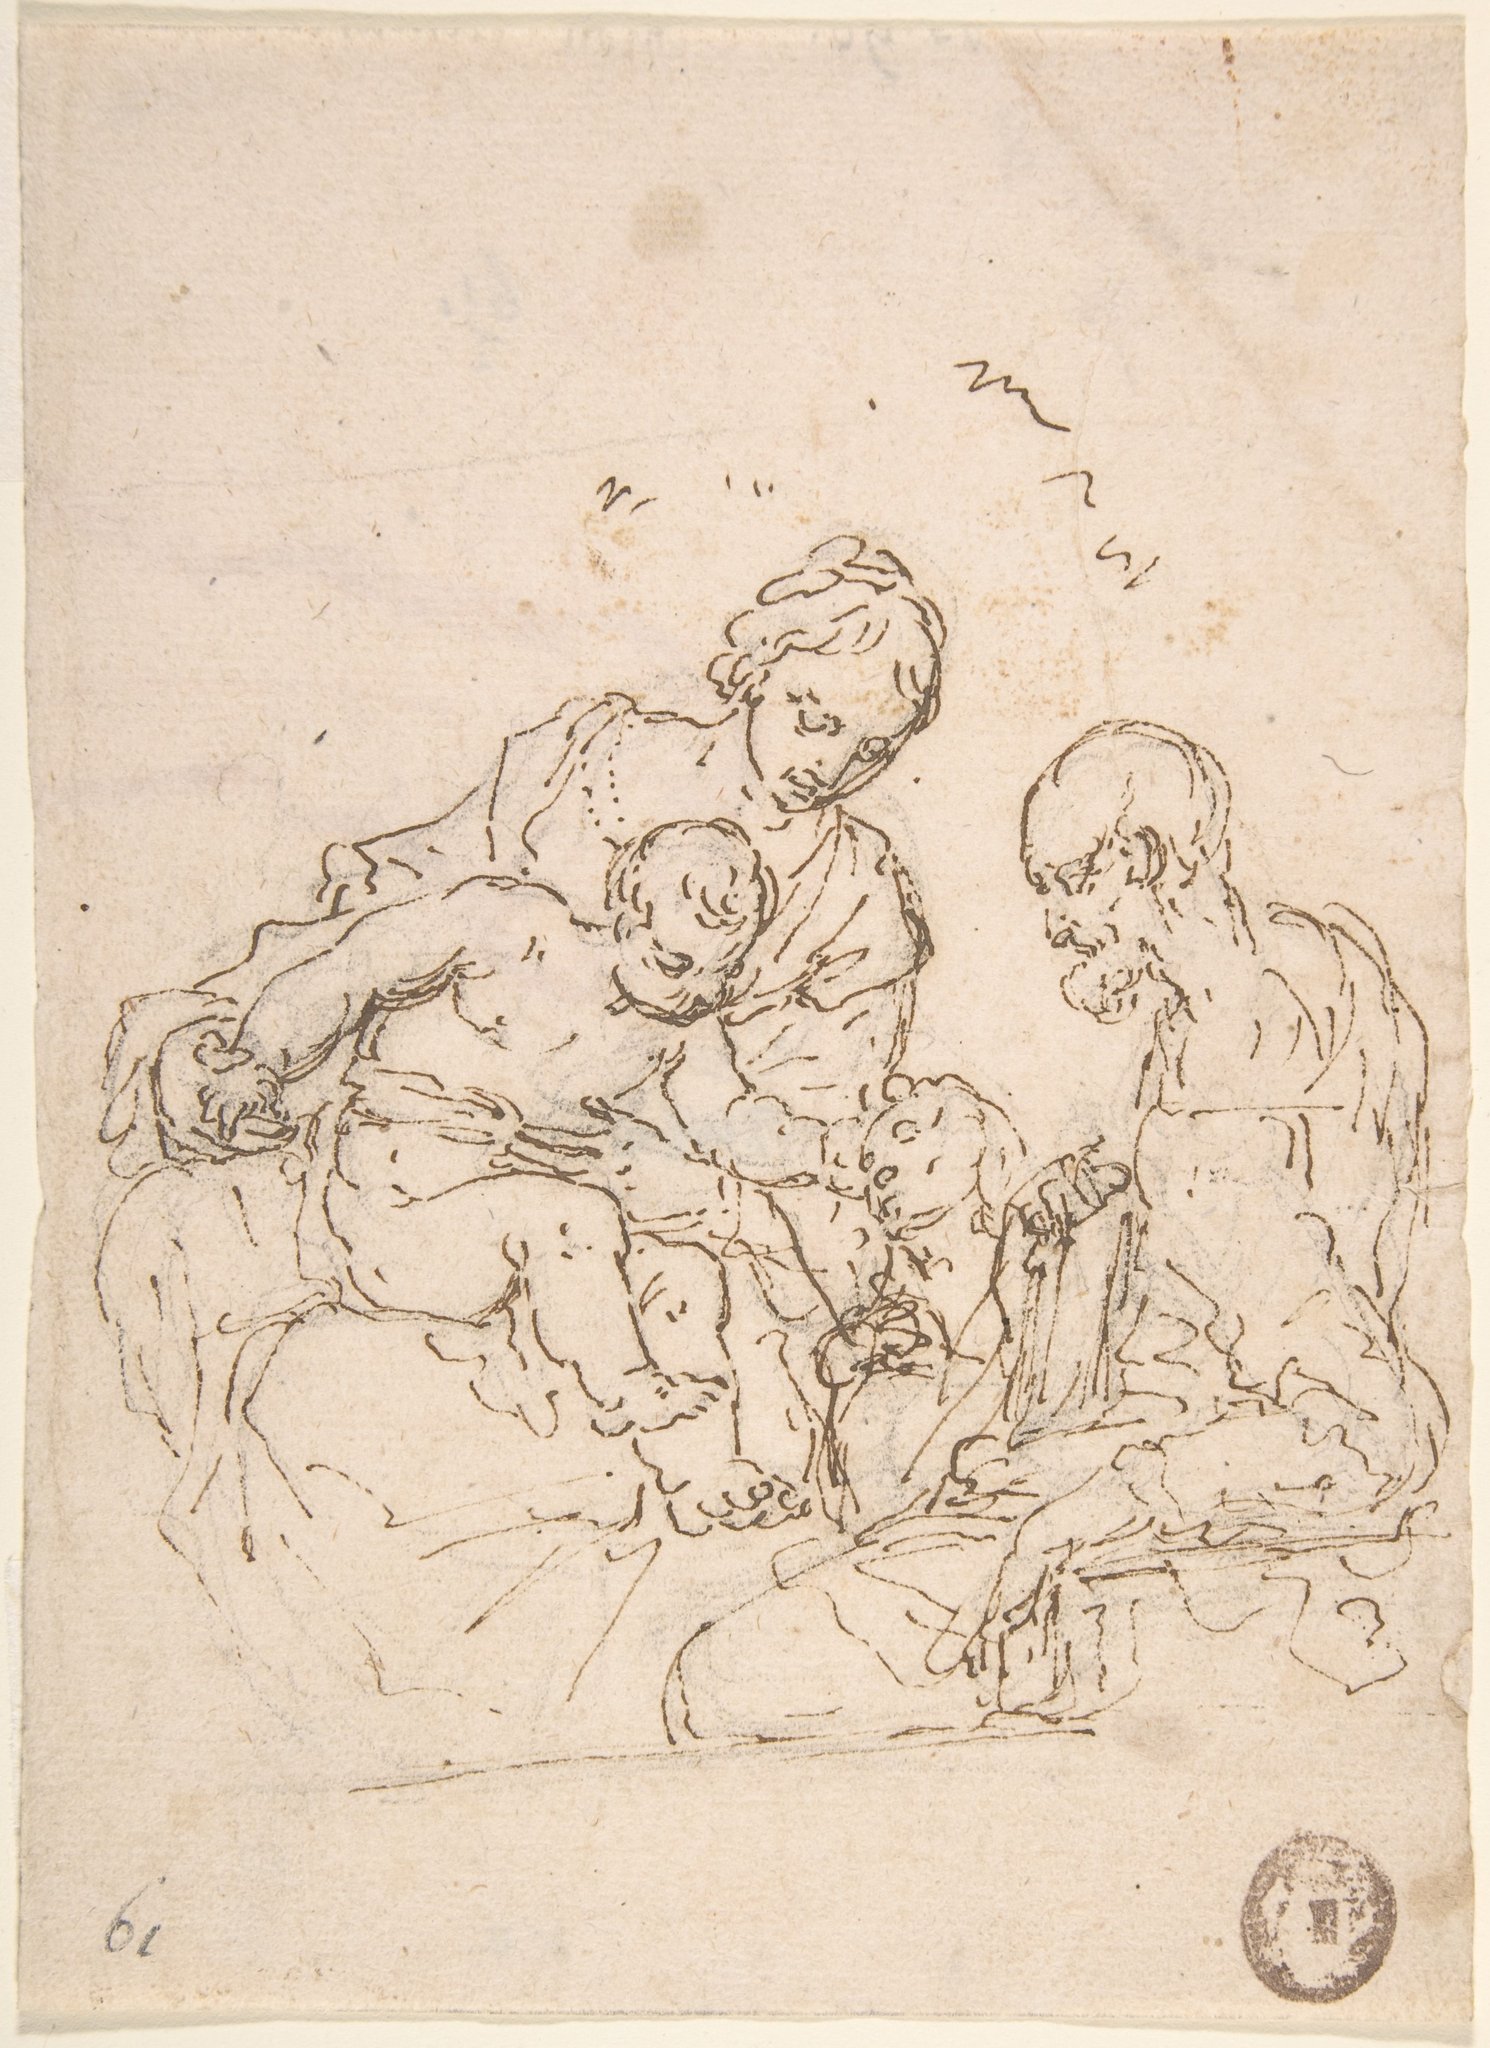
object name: drawing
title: Holy Family with St. John the Baptist (recto); Study of a Foot (verso)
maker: anonymous, italian, 17th century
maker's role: artist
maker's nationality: italian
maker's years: 1600-1700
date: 1601-1700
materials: chalk, ink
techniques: pen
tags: holy family,saint john the baptist